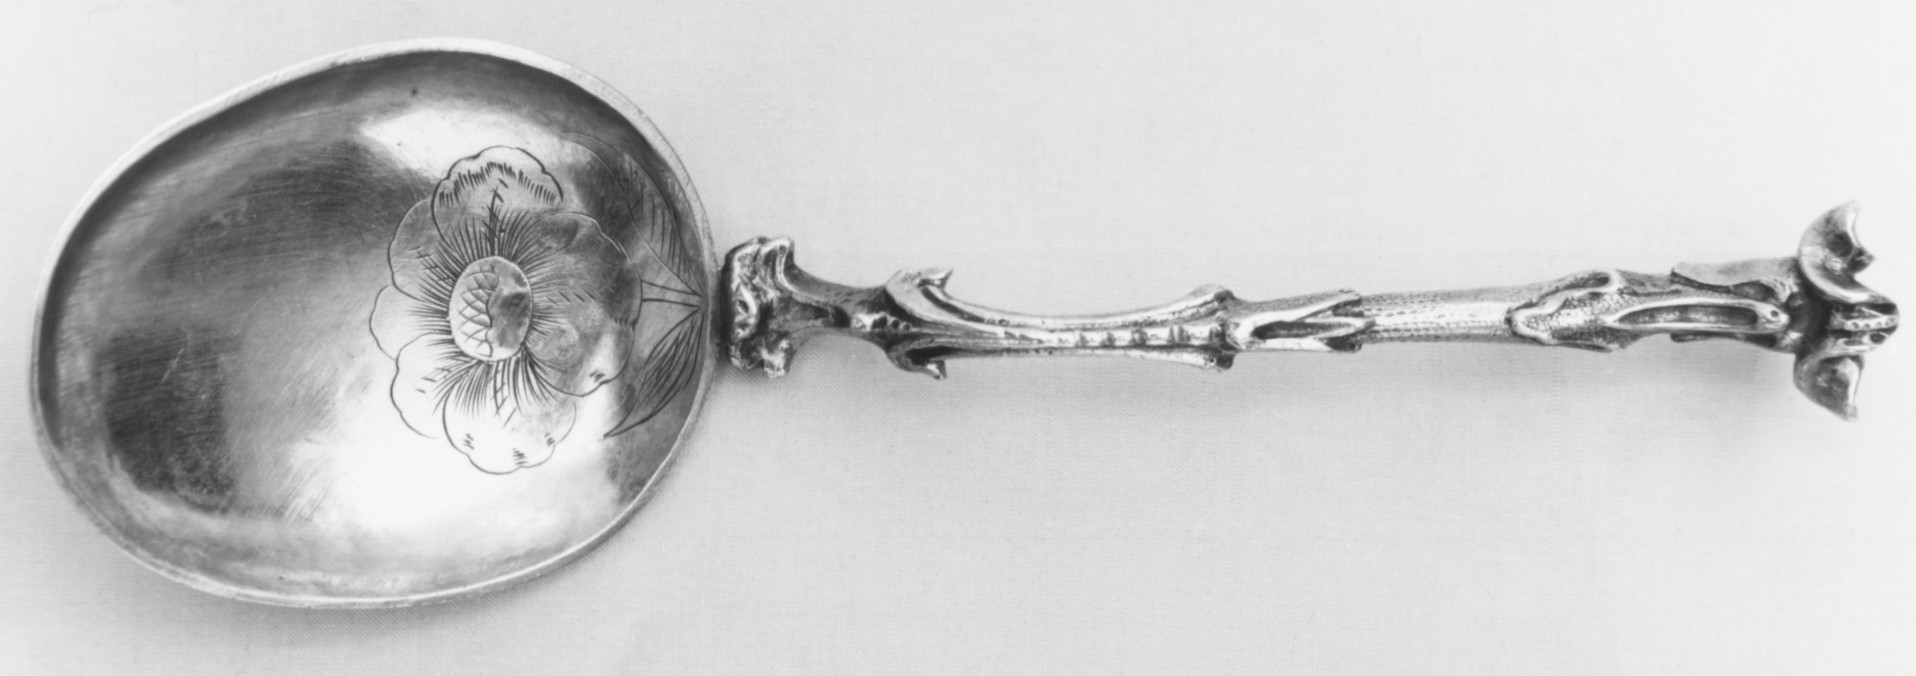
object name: spoon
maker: leonhard rothaer i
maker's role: maker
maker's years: 1671-1690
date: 1667-1700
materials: silver gilt